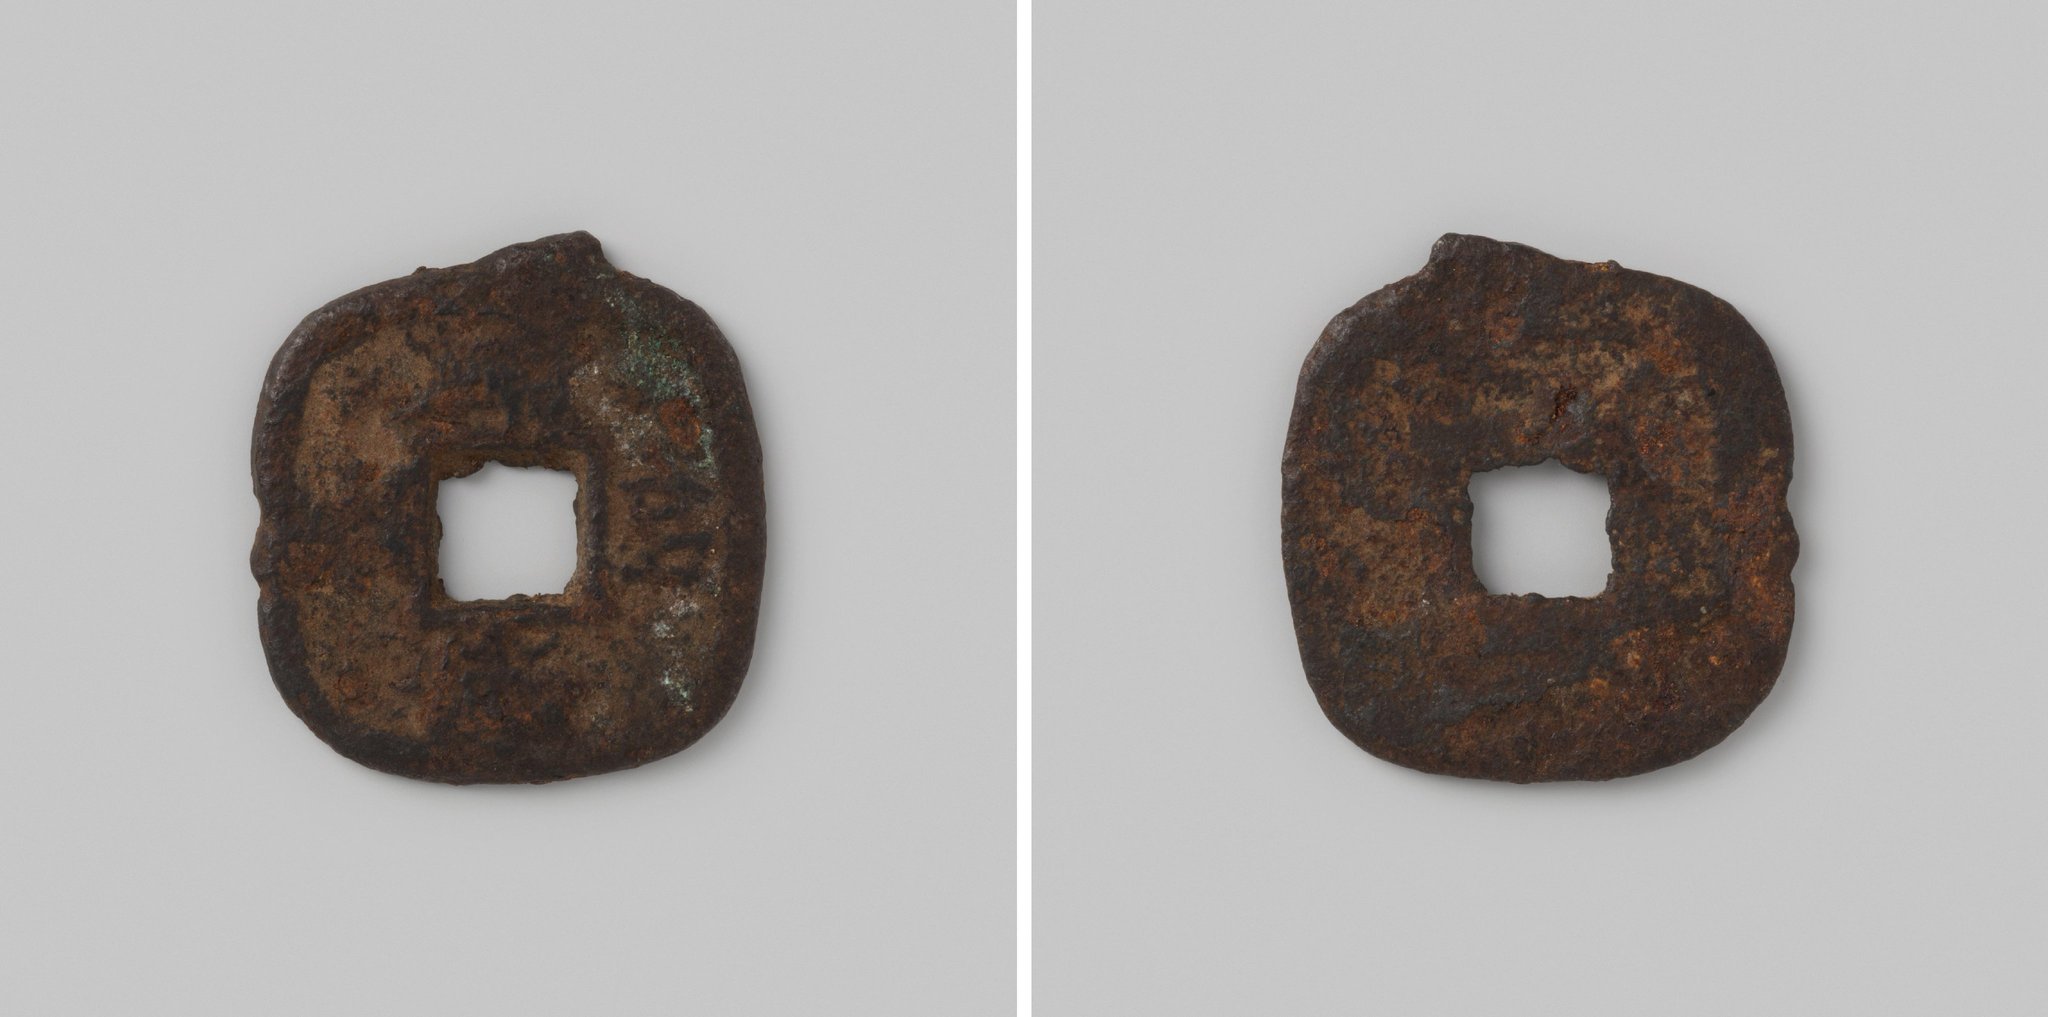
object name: mon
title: Sen van 1 mon uit het keizerrijk Japan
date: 1739-1868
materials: iron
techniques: casting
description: IJzeren rechthoekige munt. Voorzijde: binnen brede gladde rand rondom vierkante uitsparing in het midden vier kruisgewijze geplaatste tekens met de betekenis: kanei tsuho [= kanei periode]. Keerzijde: binnen brede gladde rand glad oppervlak??